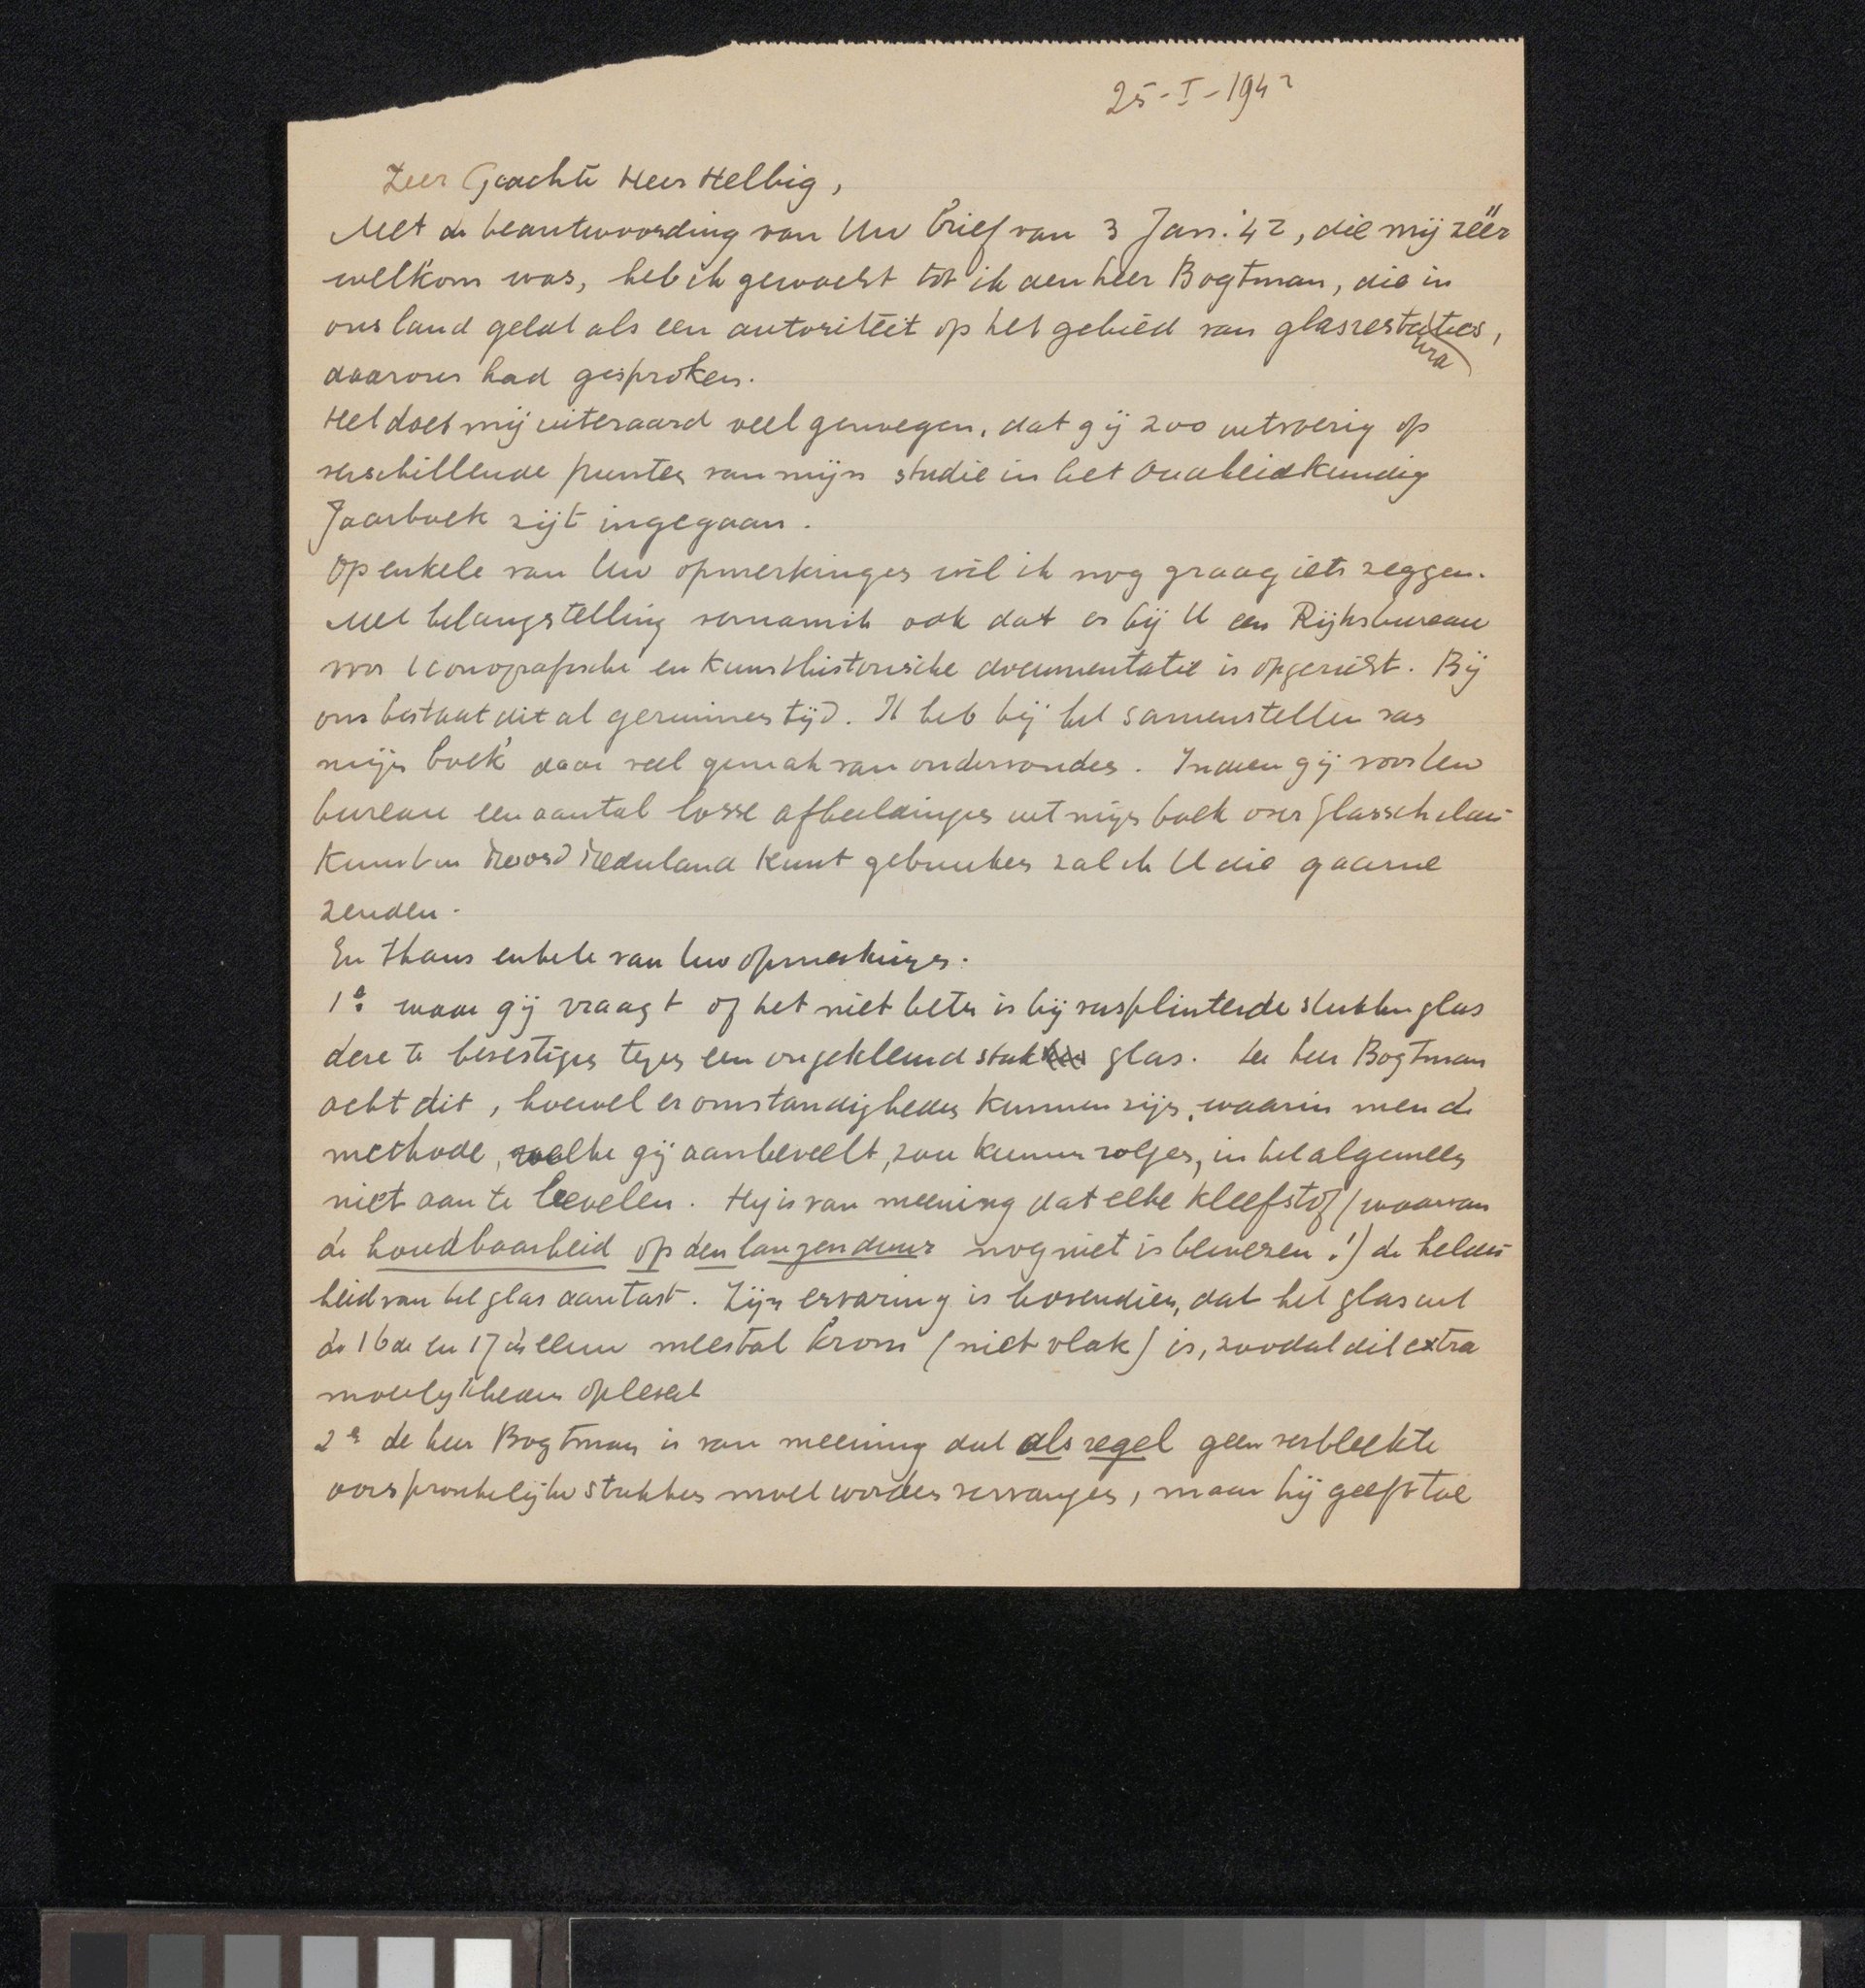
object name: letter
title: Brief aan Jean Helbig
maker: a. van der boom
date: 1942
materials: ink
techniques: pen, writing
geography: brussels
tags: jean helbig, haarlem, willem bogtman, amsterdam, painter, iohan quirijn van regteren altena, drawing, applied arts, arts and crafts; industrial design, photography, cinematography, printed matter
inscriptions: collector's mark: Lugt L.2228a